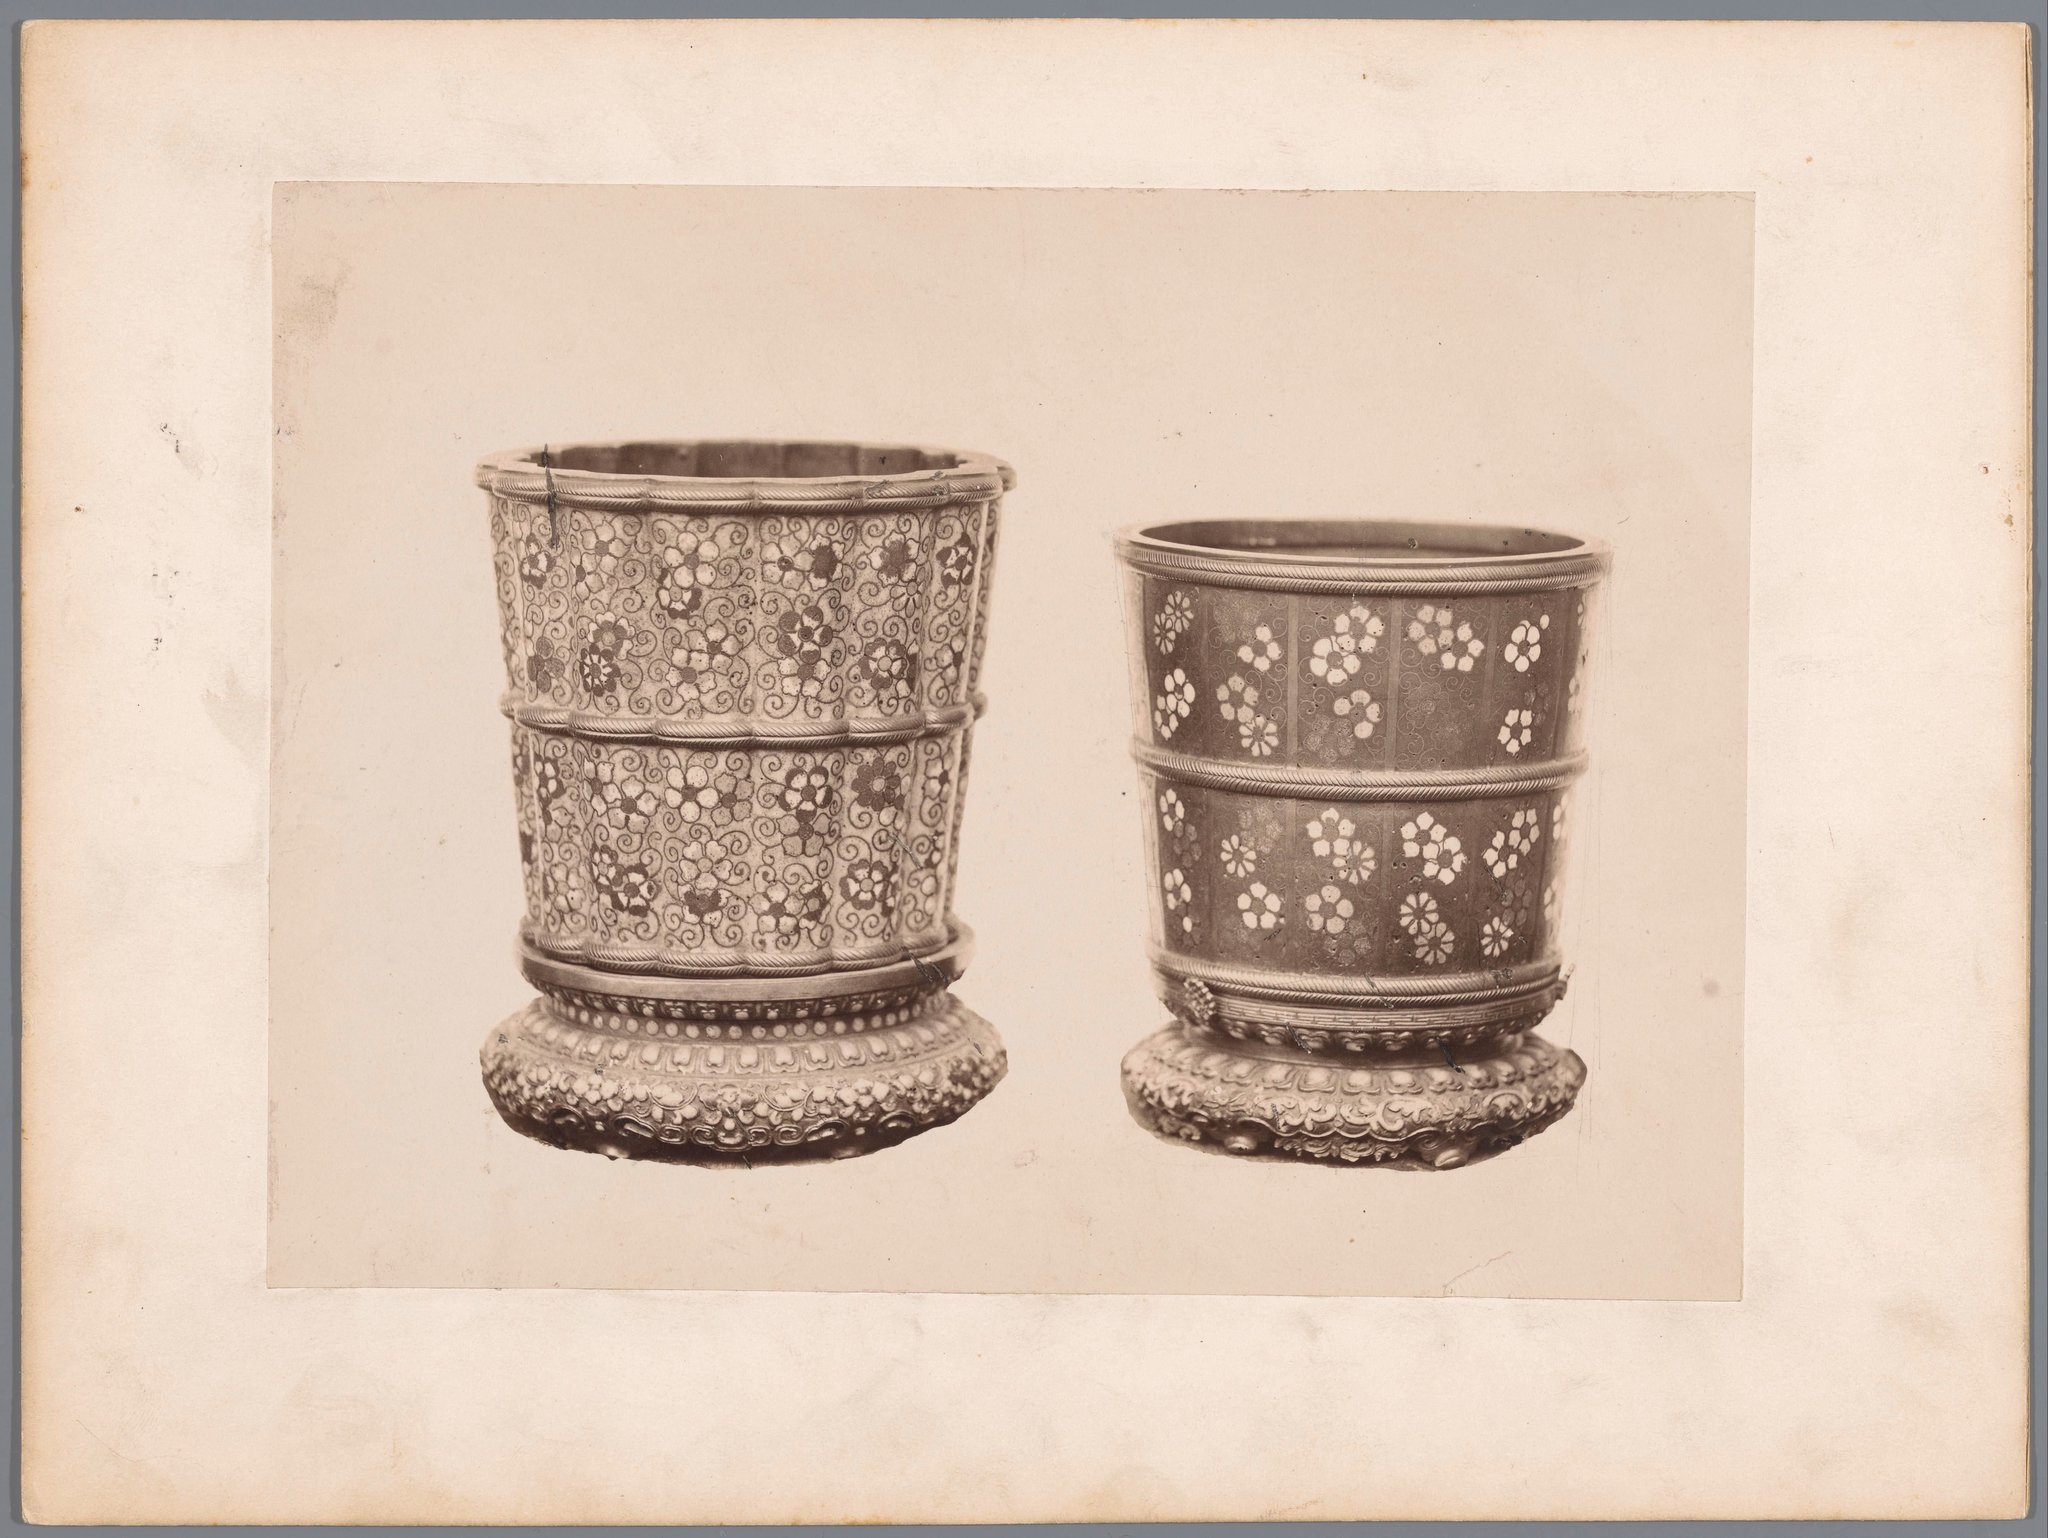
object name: photograph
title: Twee bekers gedecoreerd met bloemmotief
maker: Anonymous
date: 1875-1900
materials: cardboard, photographic support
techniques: albumen print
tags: applied arts, arts and crafts; industrial design, container of ceramics: jar, jug, pot, vase, ornament derived from plant forms, flowers ~ ornament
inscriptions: collector's mark: Lugt 3937